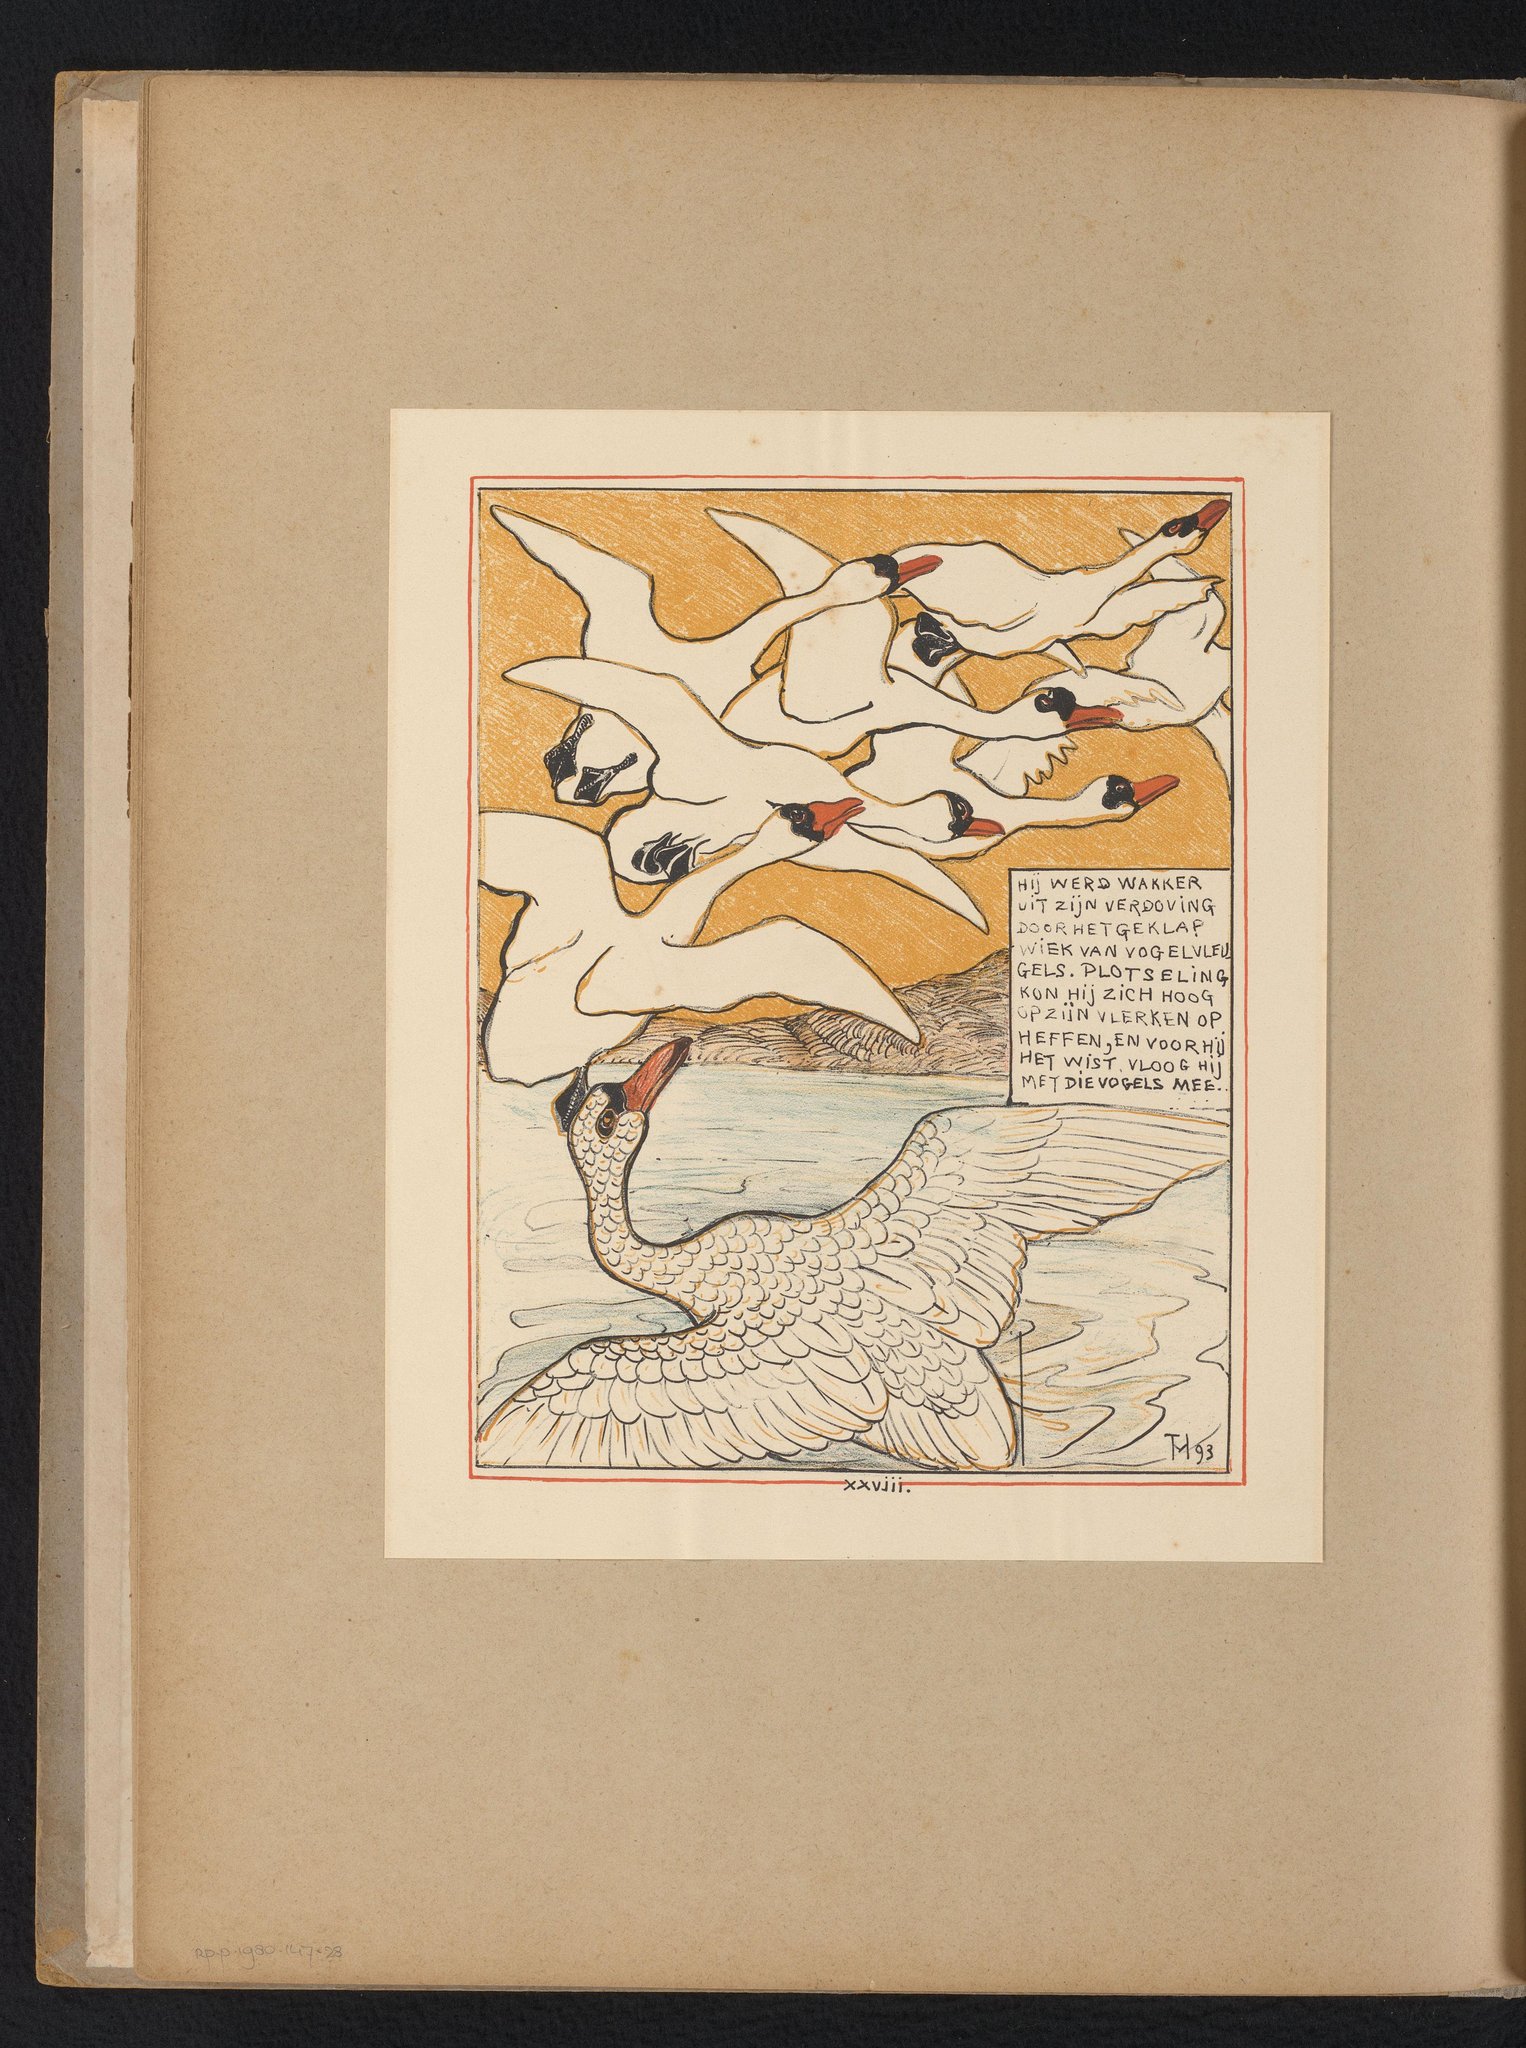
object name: print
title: Het leelijke jonge eendje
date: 1893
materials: paper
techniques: lithograph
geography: the hague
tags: water-birds: swan, flying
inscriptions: date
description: Deze prent maakt deel uit van een album.